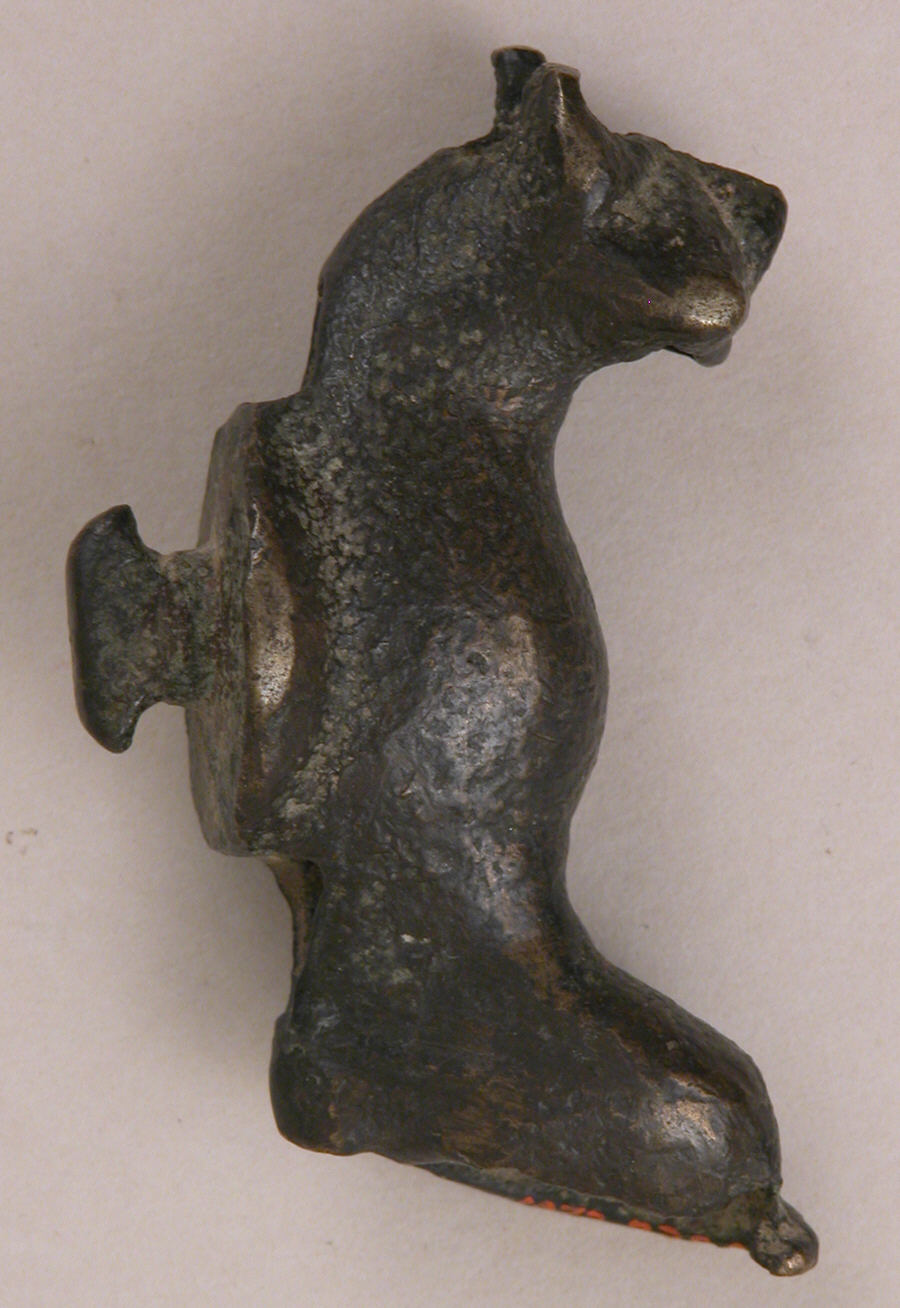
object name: foot of a vessel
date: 1001-1200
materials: bronze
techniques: casting, chasing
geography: iran